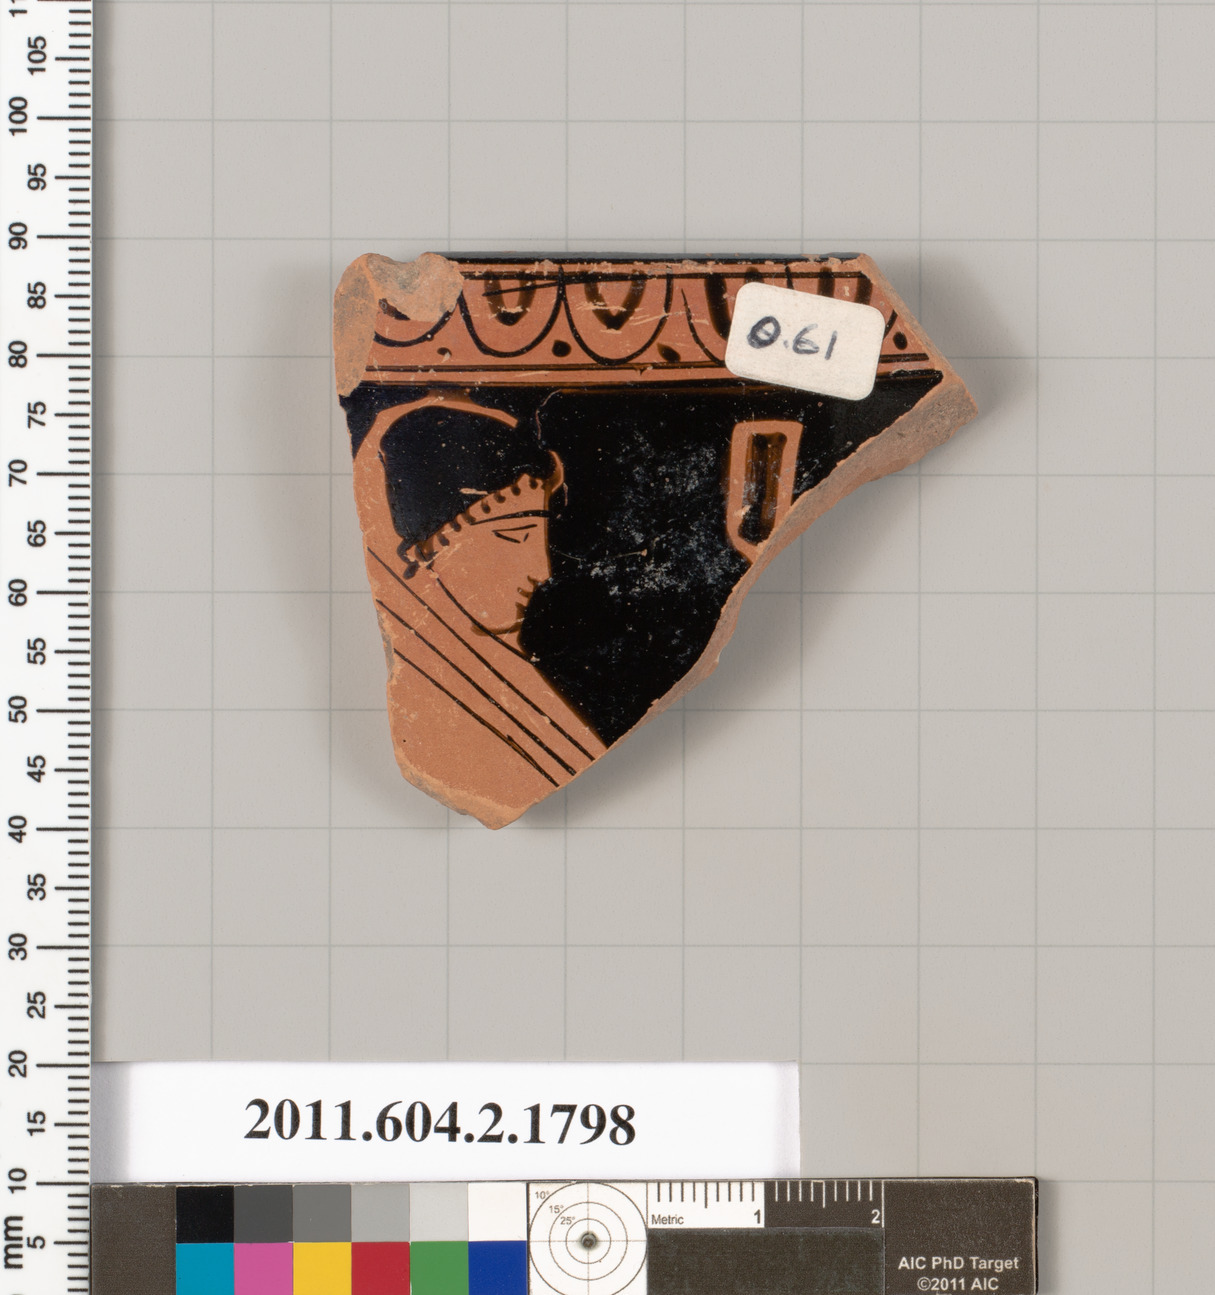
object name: skyphos fragment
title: Terracotta rim fragment of a skyphos (deep drinking cup)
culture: greek, attic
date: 425-401 BCE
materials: terracotta